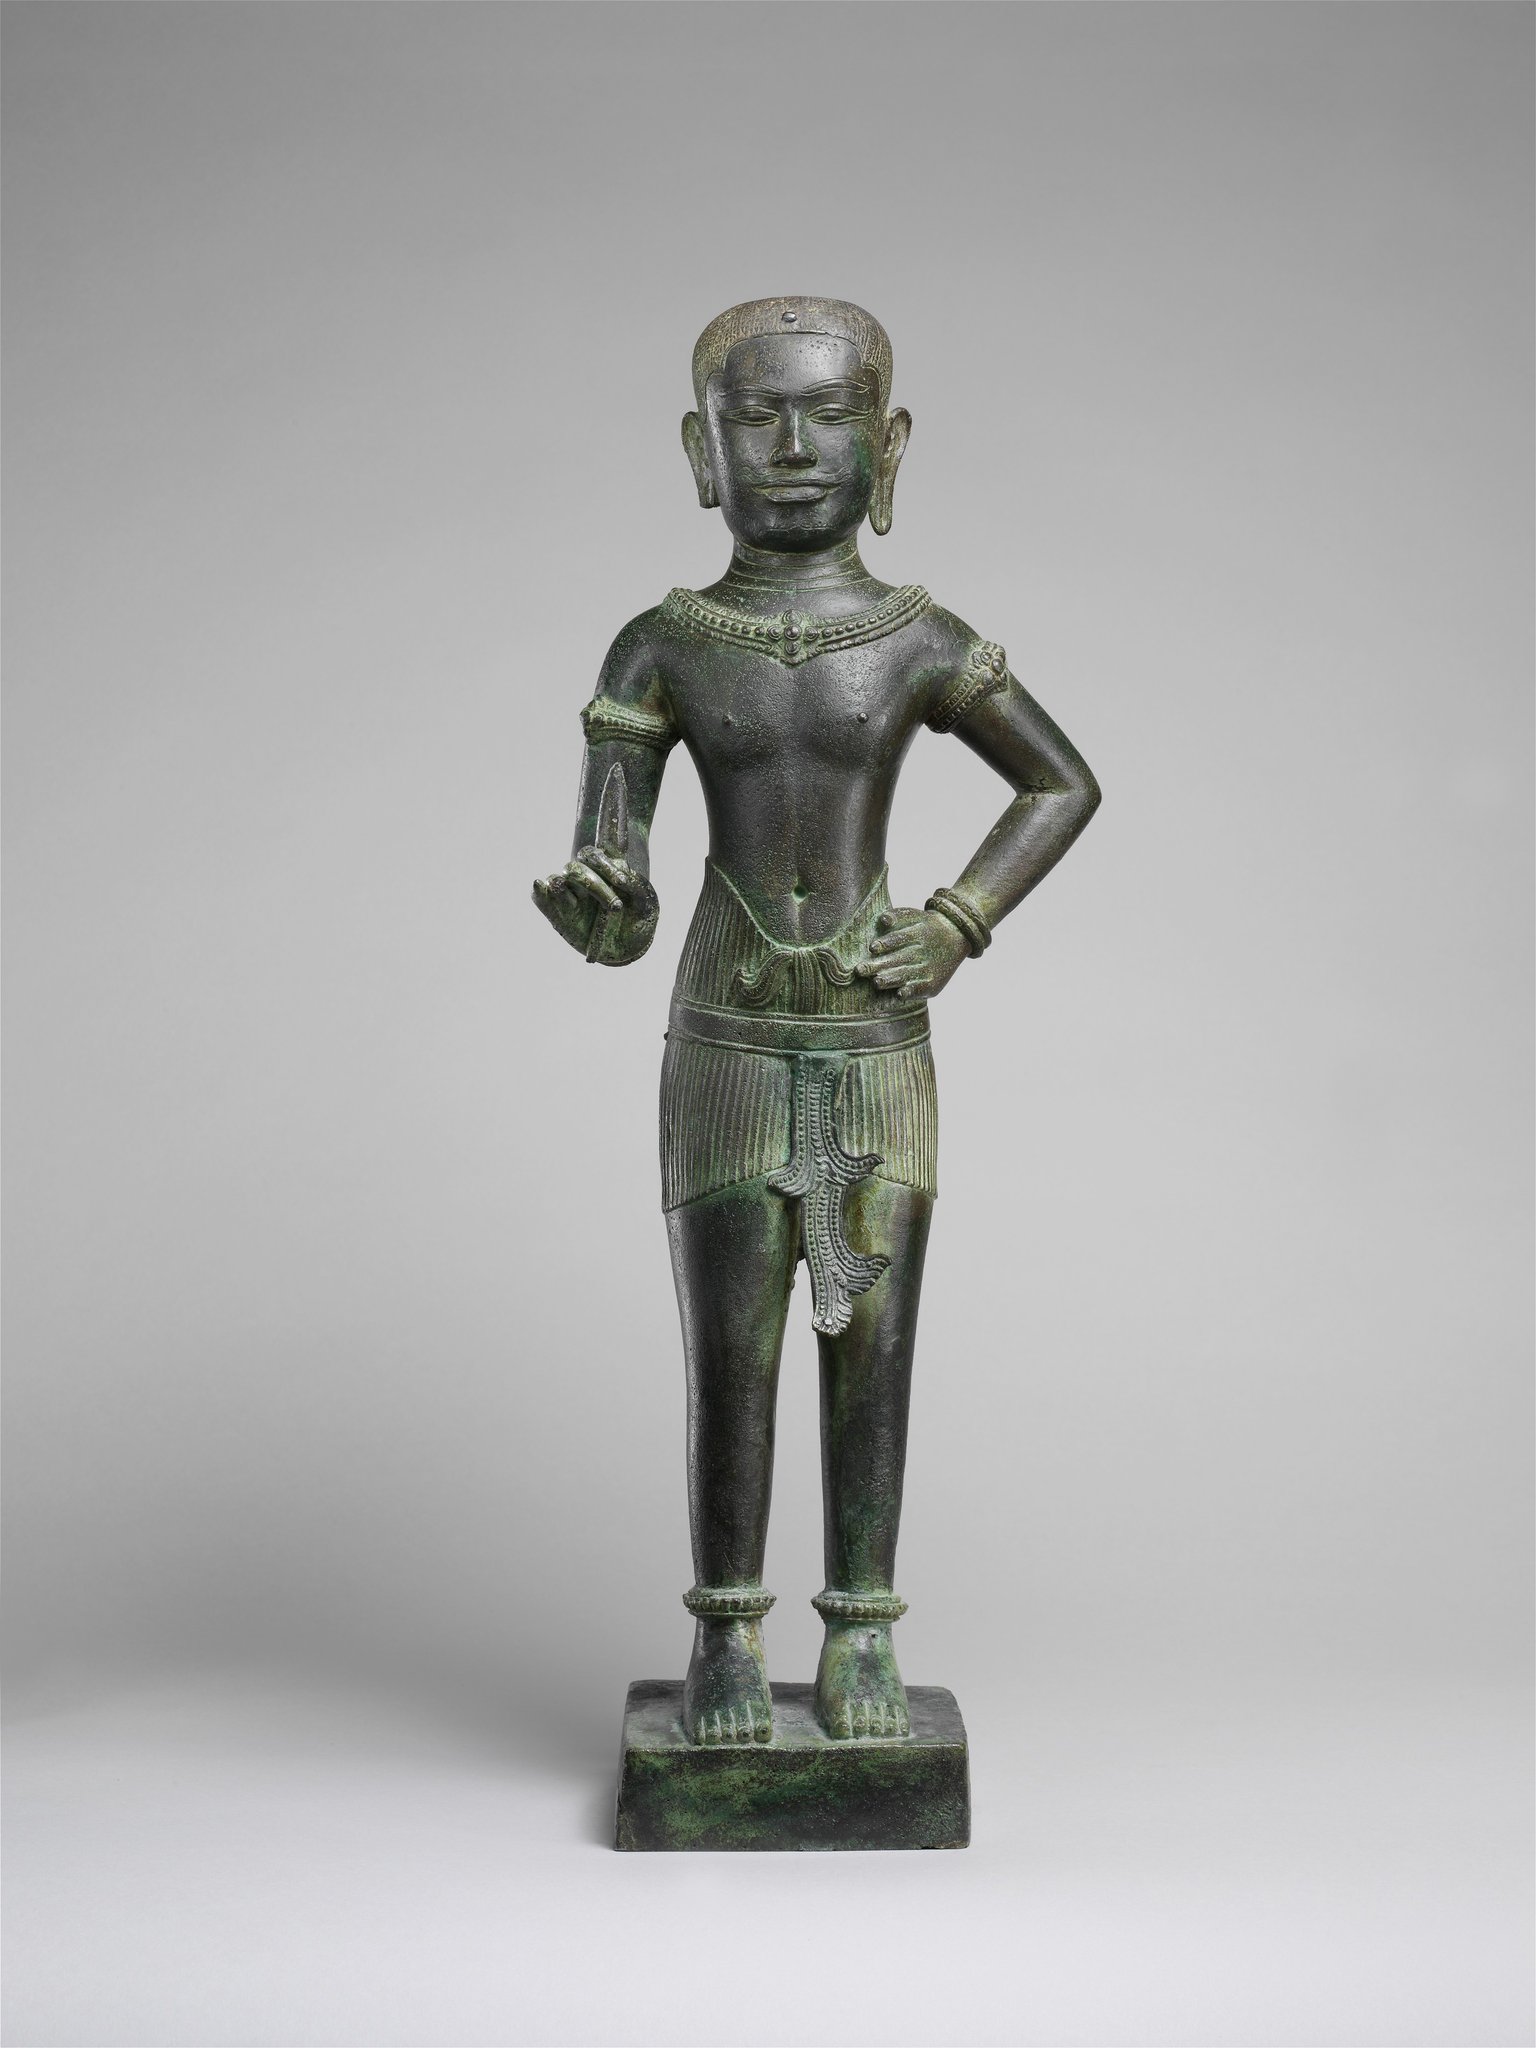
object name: figure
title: Standing Male Deity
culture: thai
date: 1051-1100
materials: bronze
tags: deities